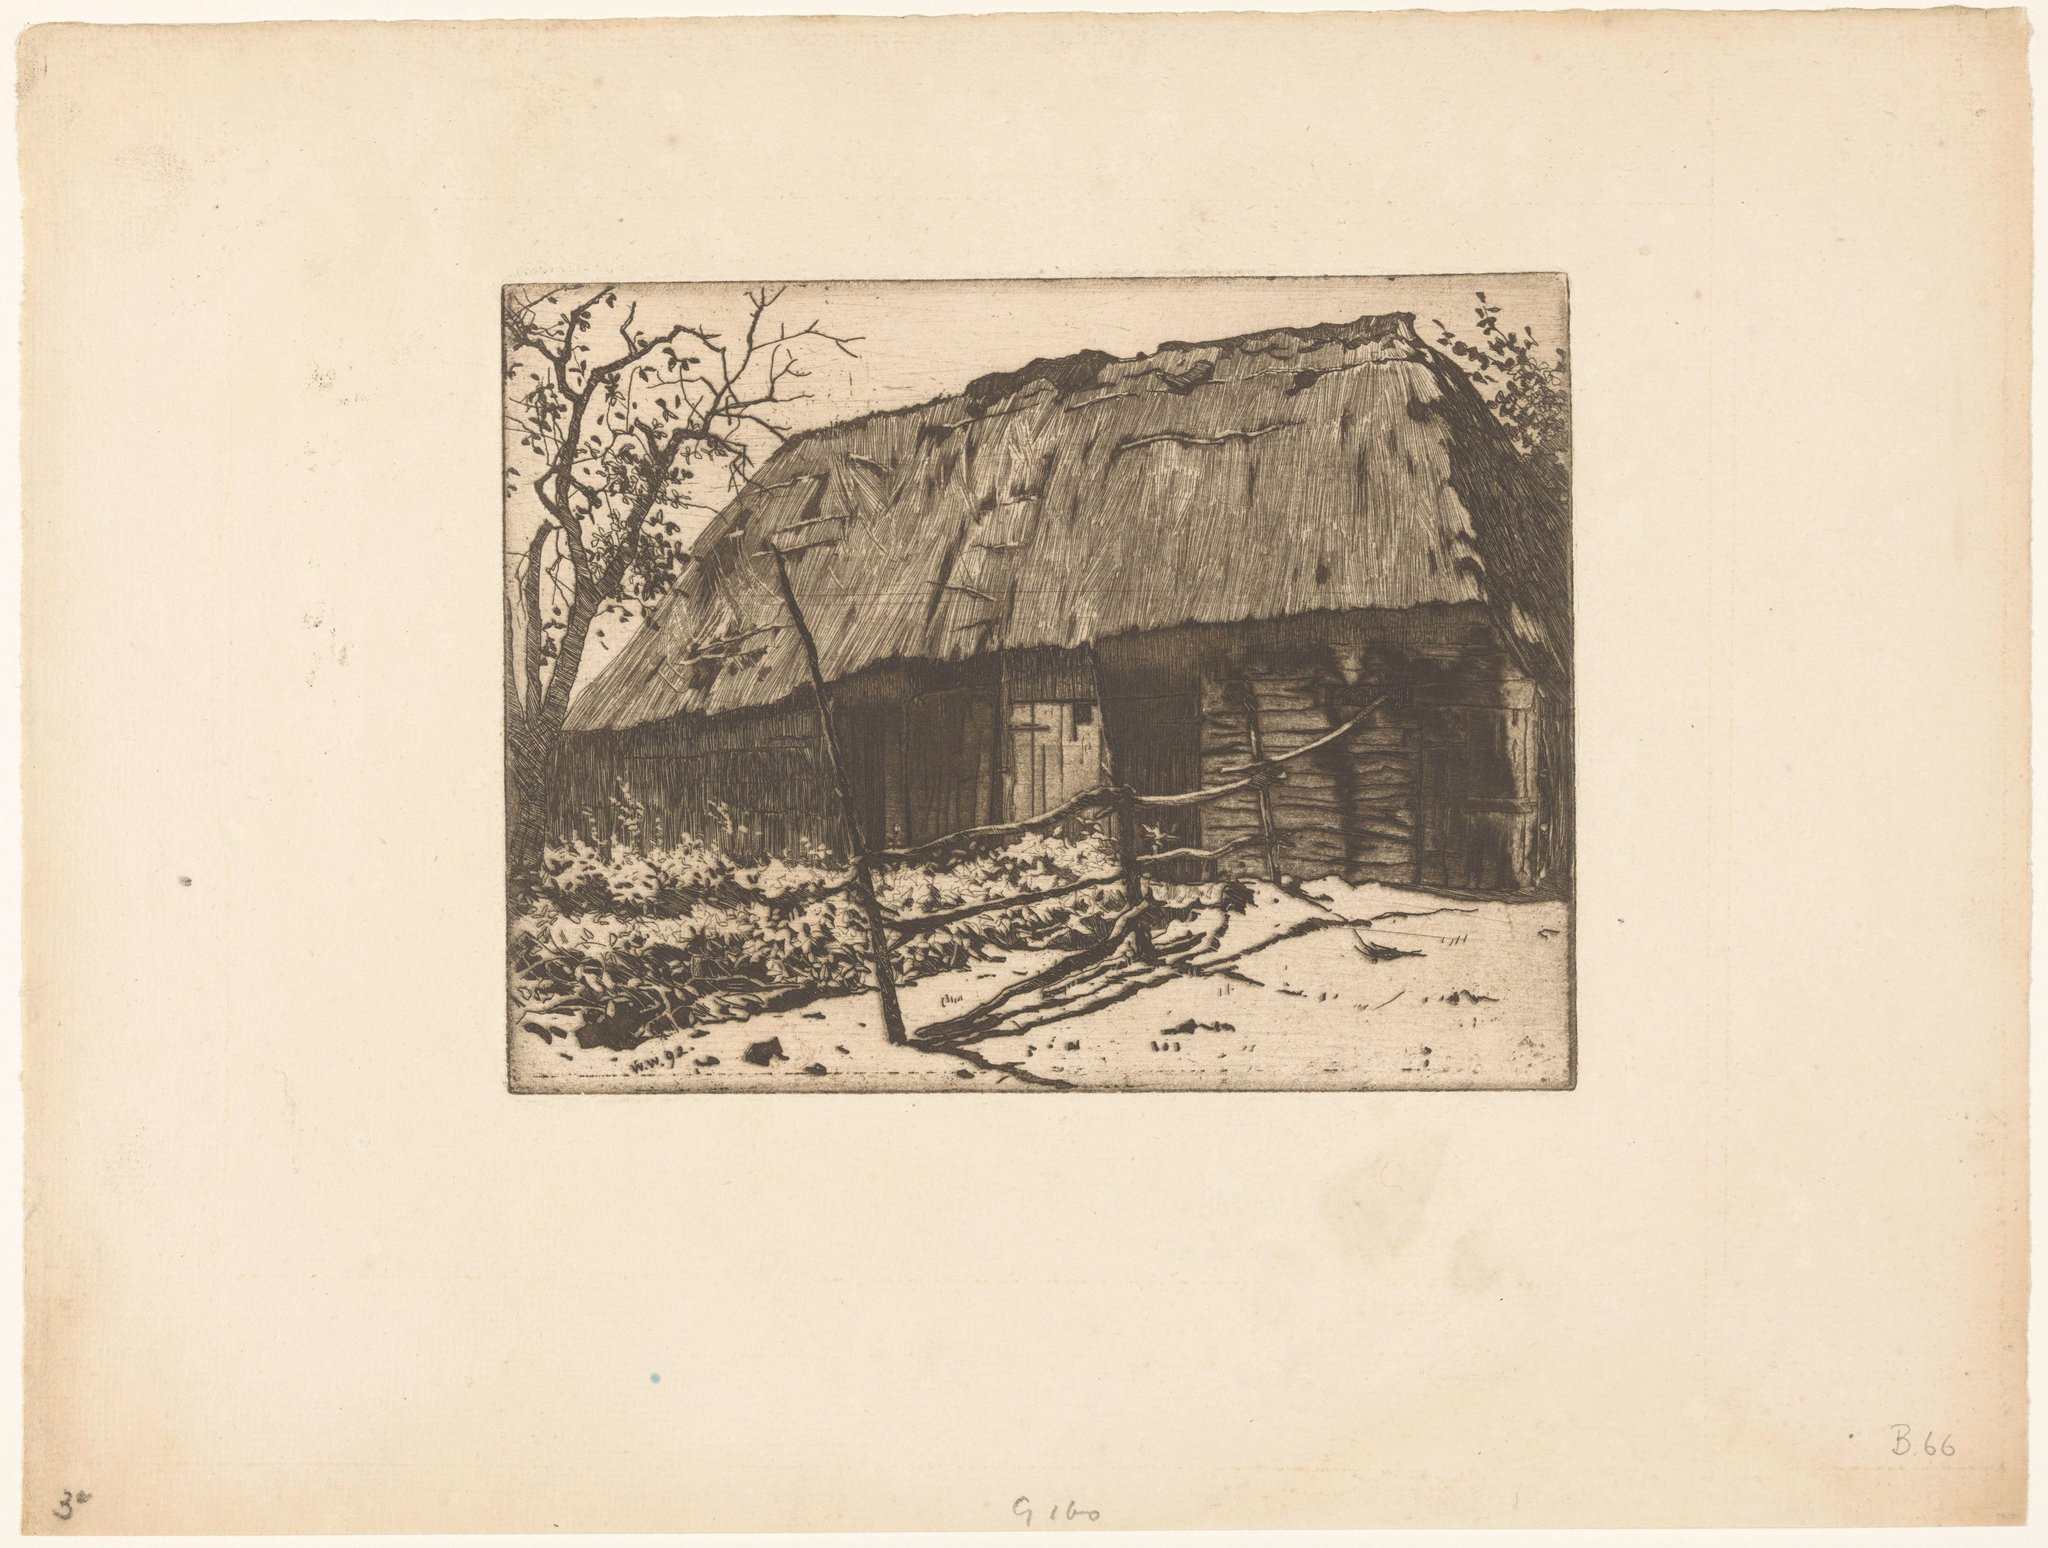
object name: print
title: Schuur met hek in Brabant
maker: willem witsen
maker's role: draughtsman, painter, print maker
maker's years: 1860-1923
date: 1892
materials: paper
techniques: aquatint, etching, intaglio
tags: barn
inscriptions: watermark